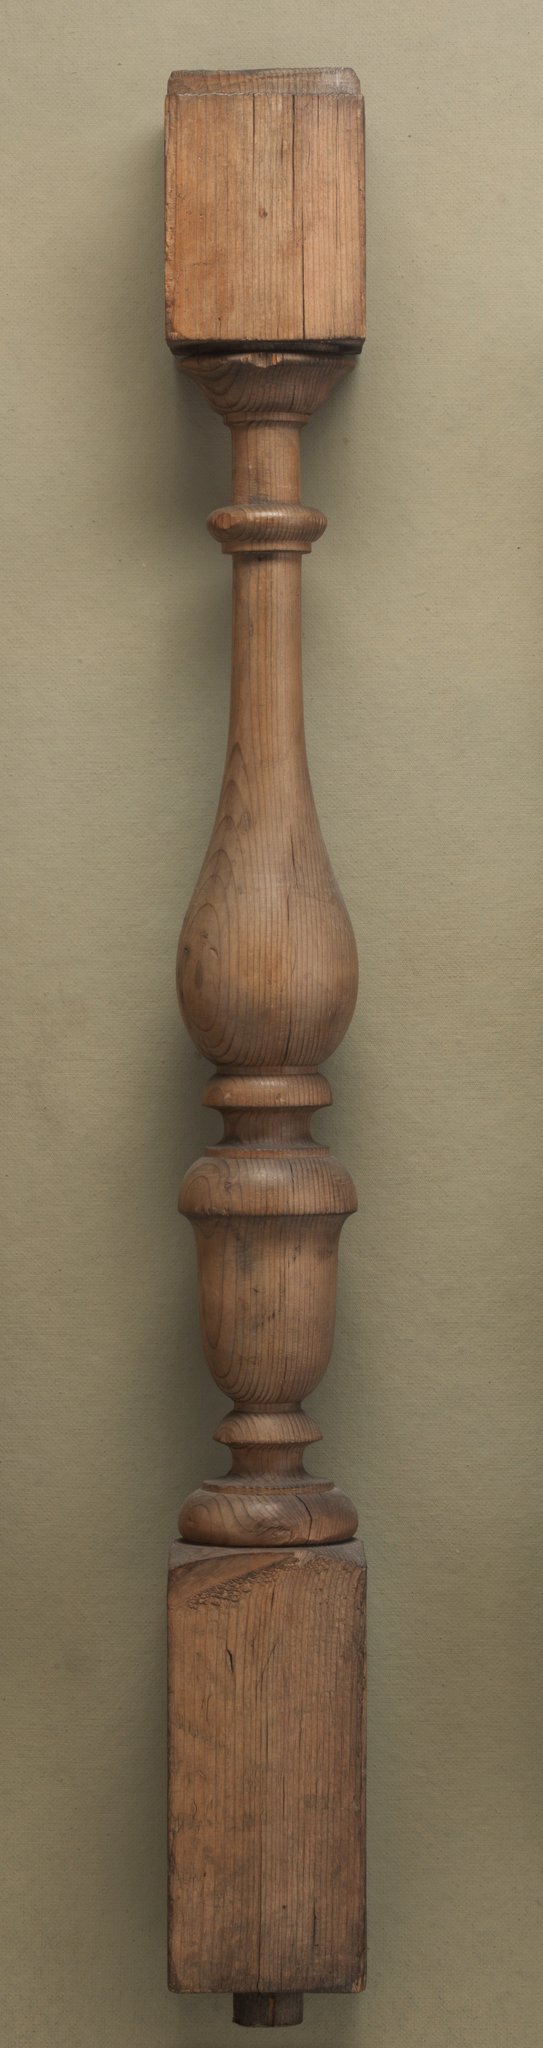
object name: baluster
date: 1667-1733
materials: wood